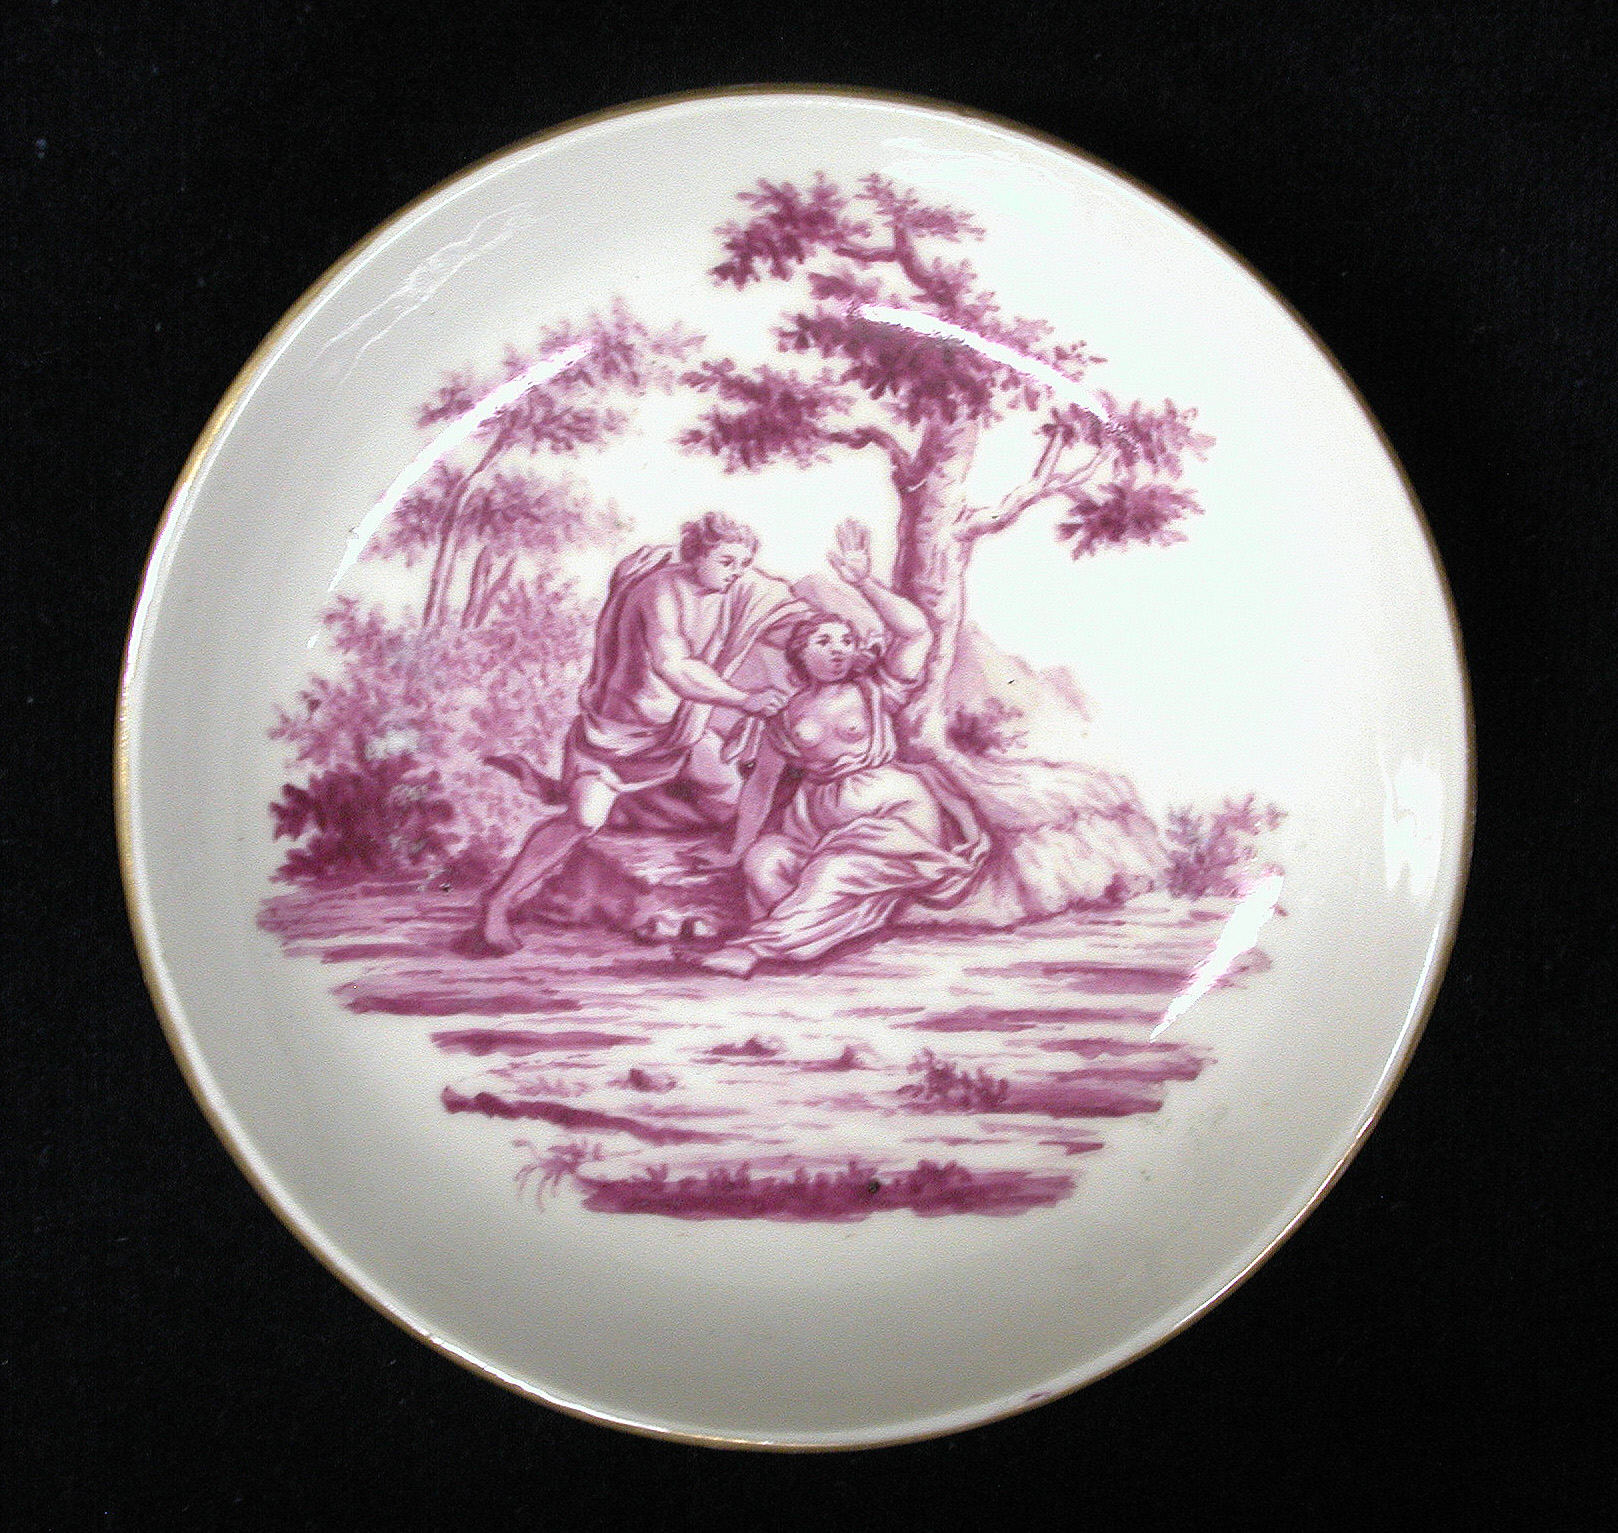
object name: saucer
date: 1760-1765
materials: hard paste porcelain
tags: men,female nudes,trees